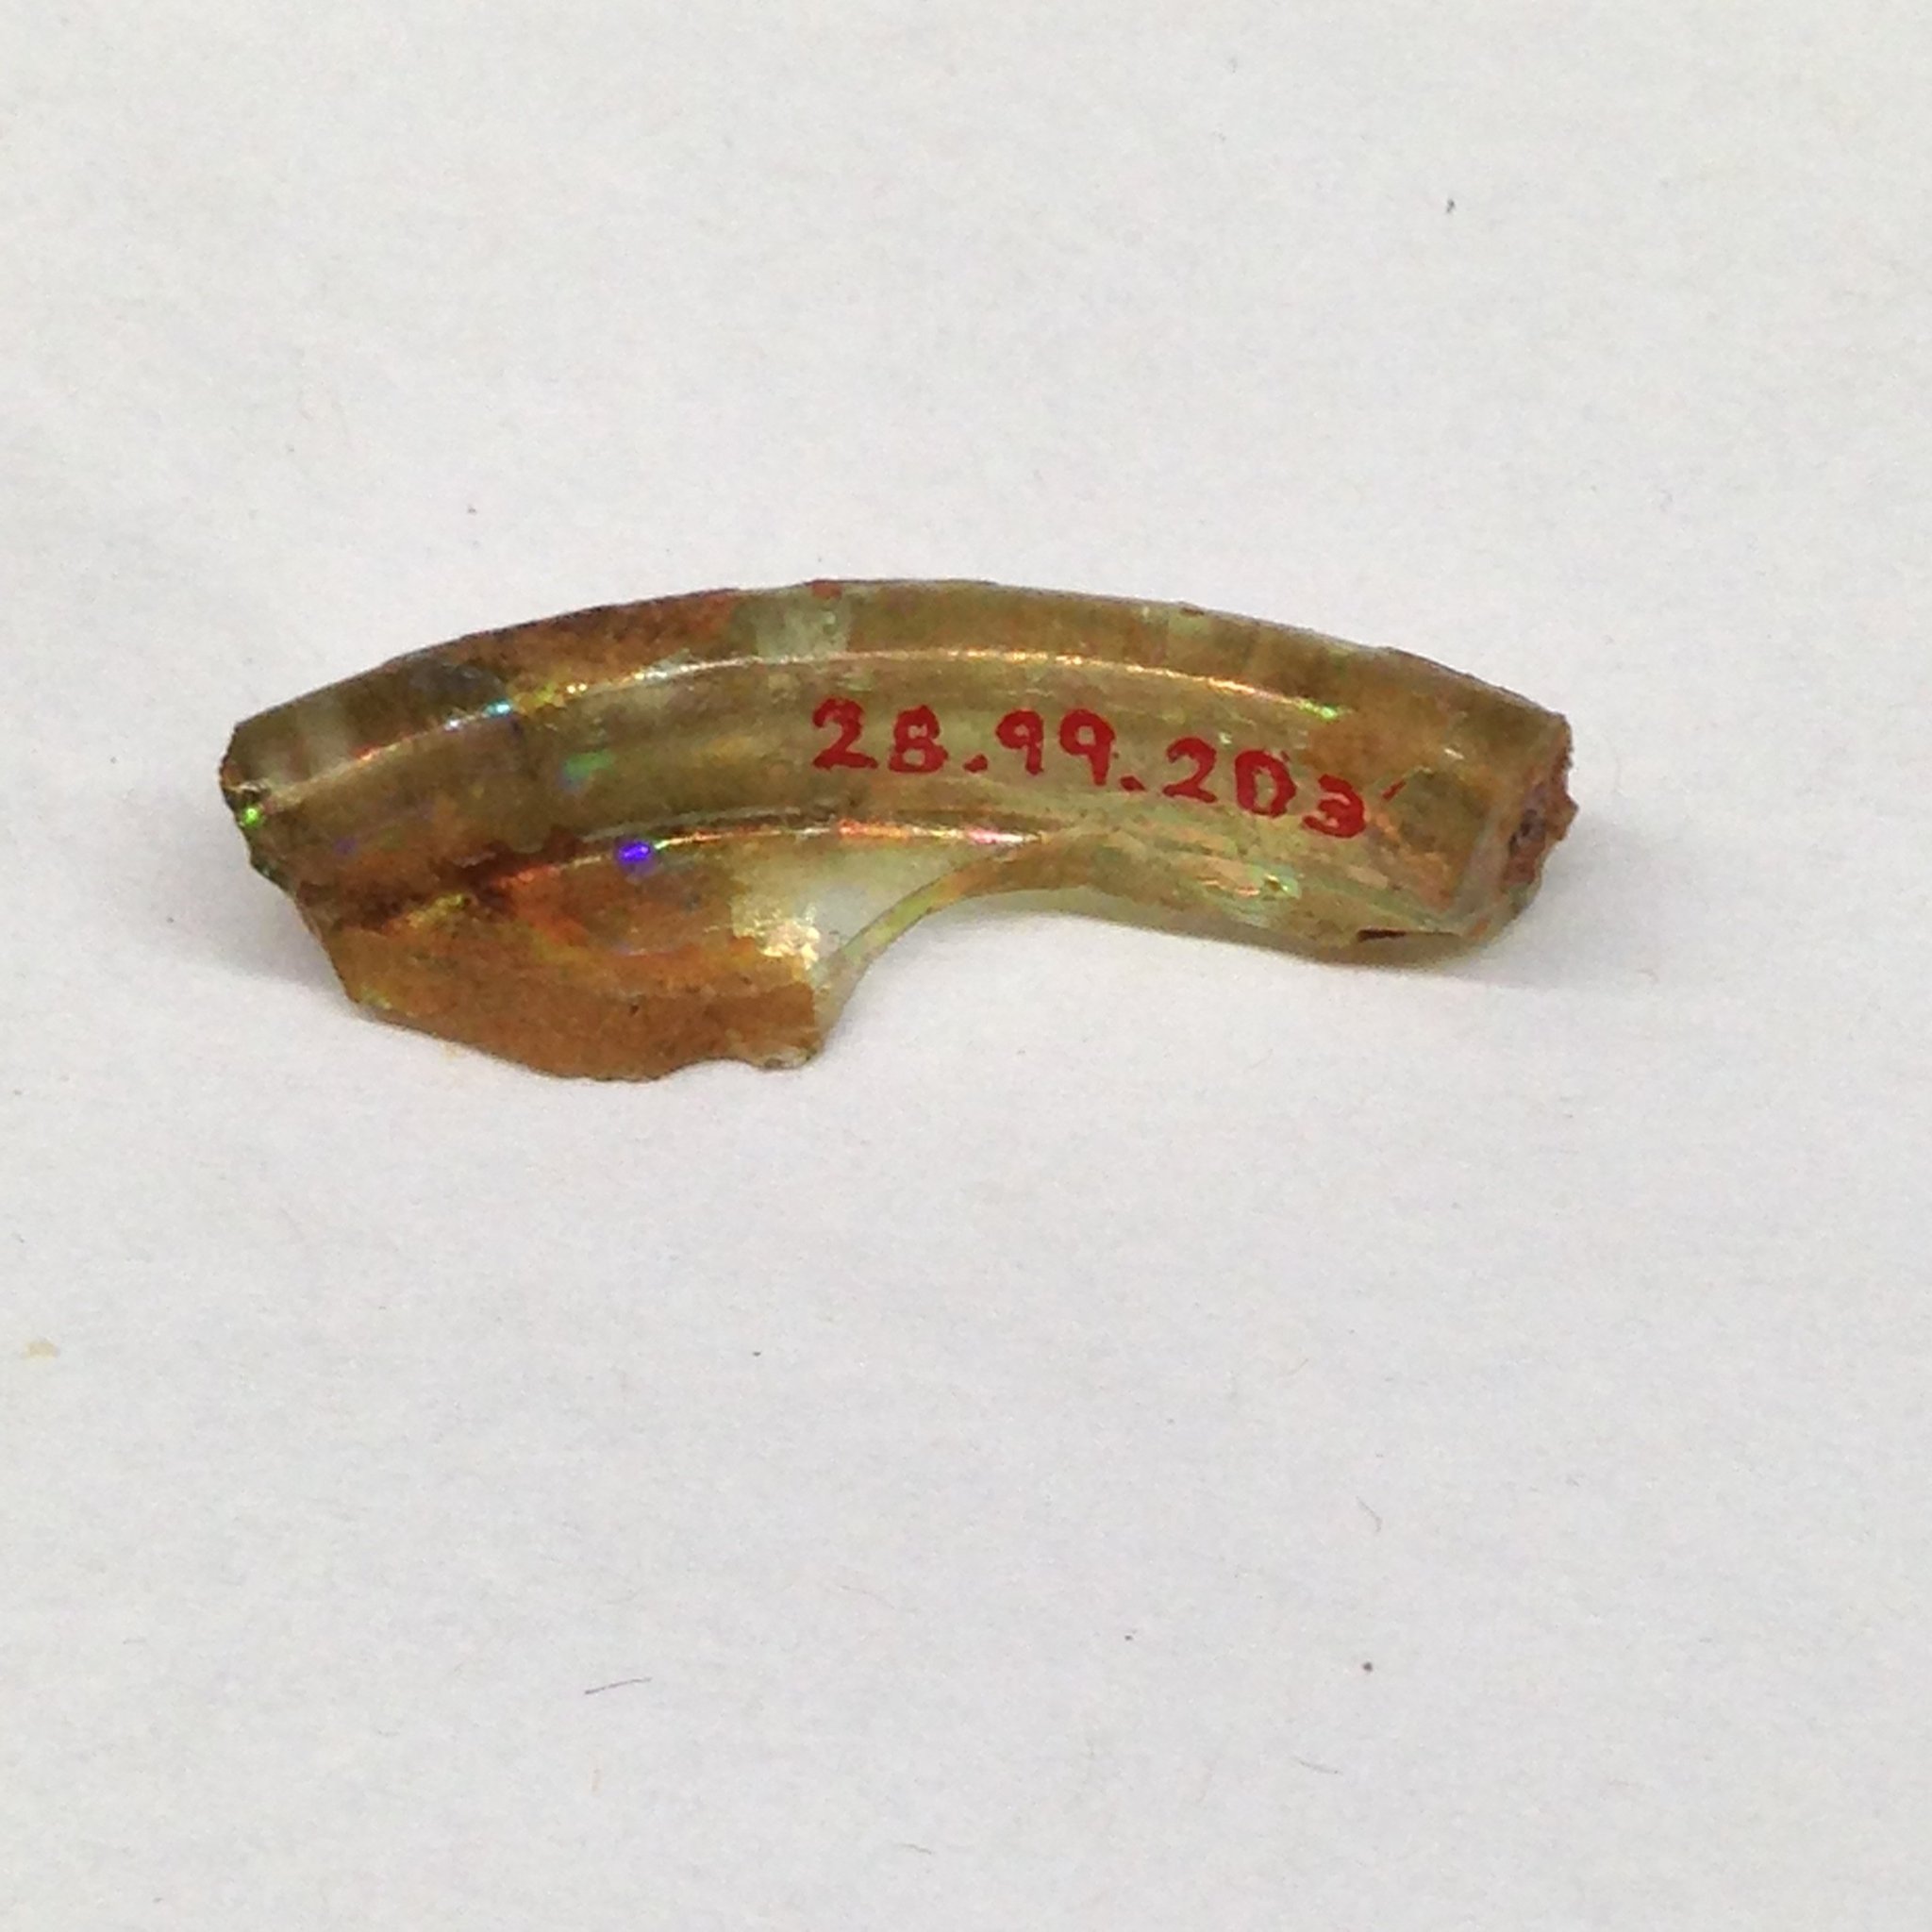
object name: fragment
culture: european or middle eastern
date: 1150-1250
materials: ceramic, glass